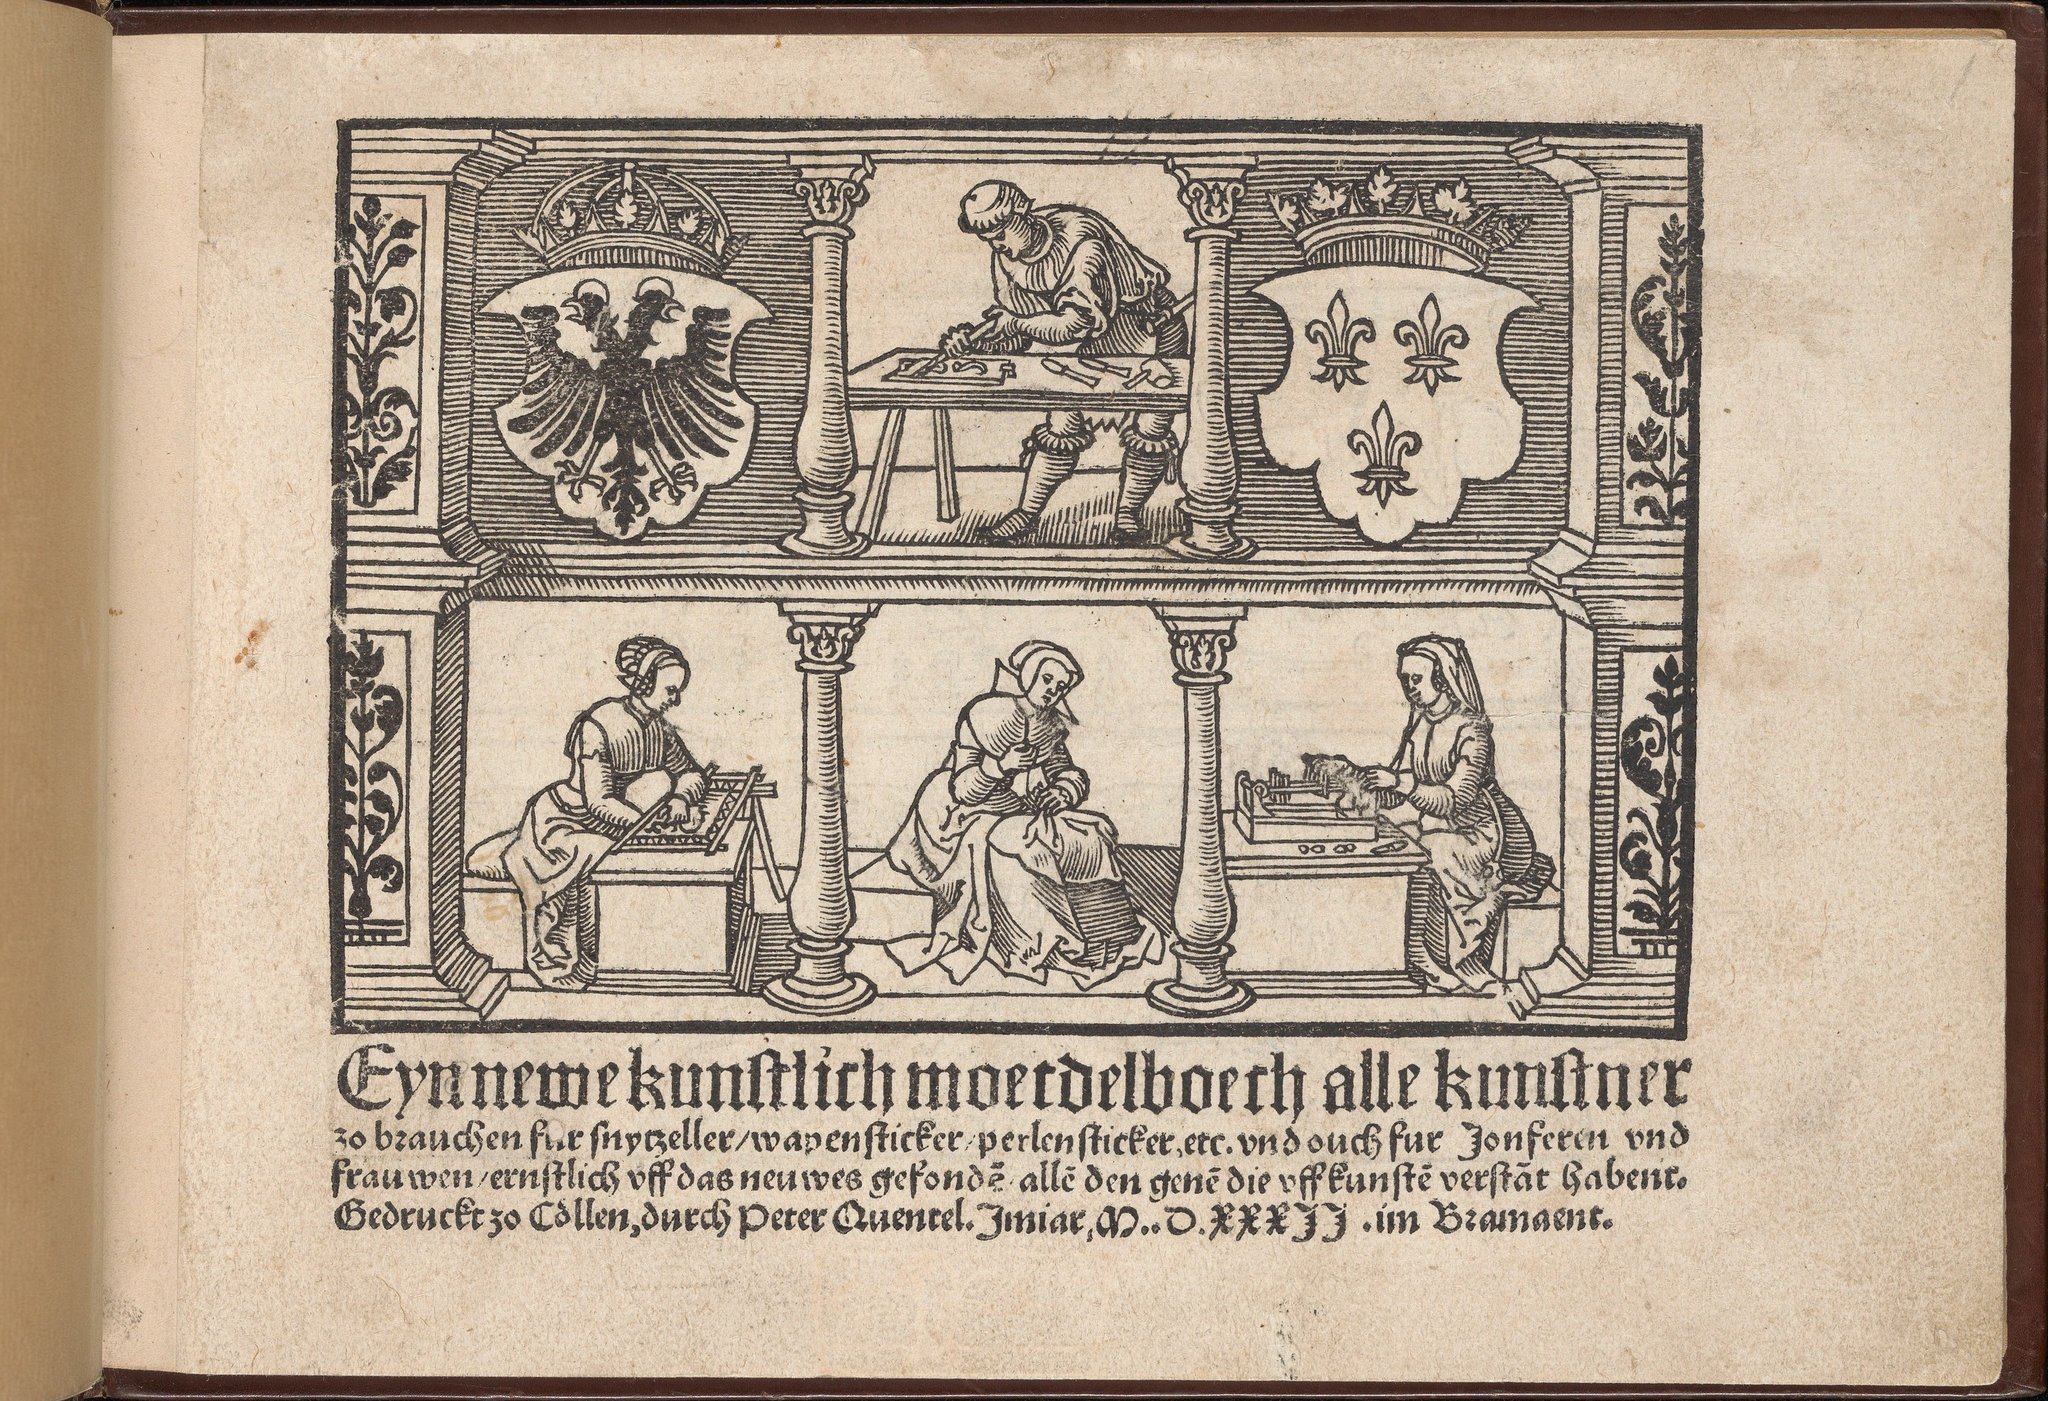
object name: book print ornament architecture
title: Titel page from Eyn Newe kunstlich moetdelboech alle kunst (Page 1r)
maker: peter quentel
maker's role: publisher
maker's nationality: german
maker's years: 1500-1550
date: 1532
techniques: woodcut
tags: men,women,working